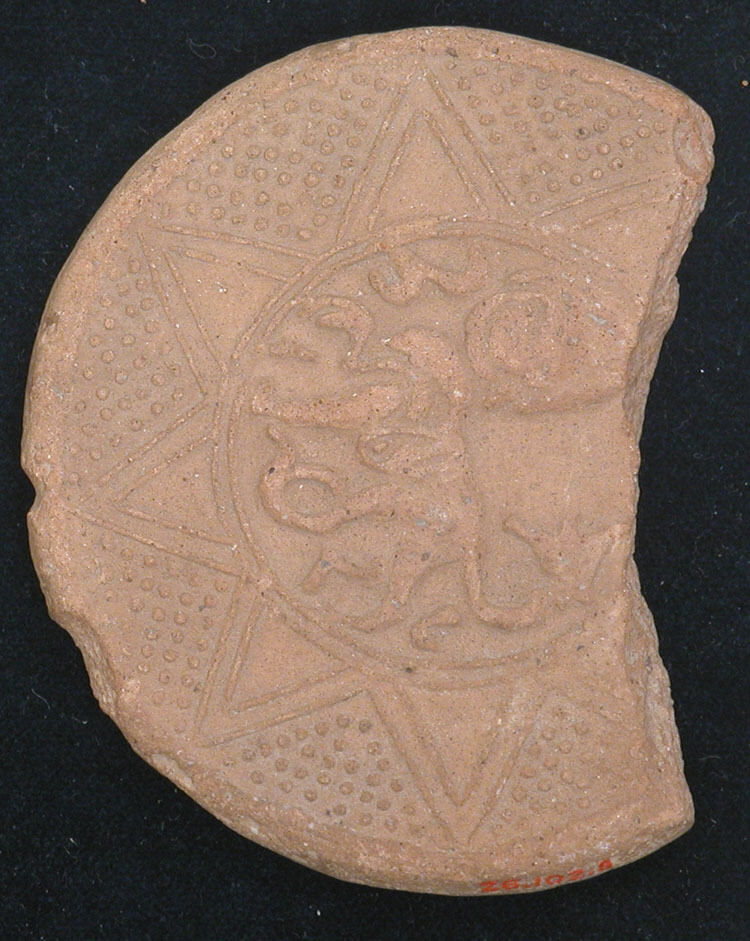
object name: bath scraper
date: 1101-1300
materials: earthenware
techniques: molding, relief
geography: iran